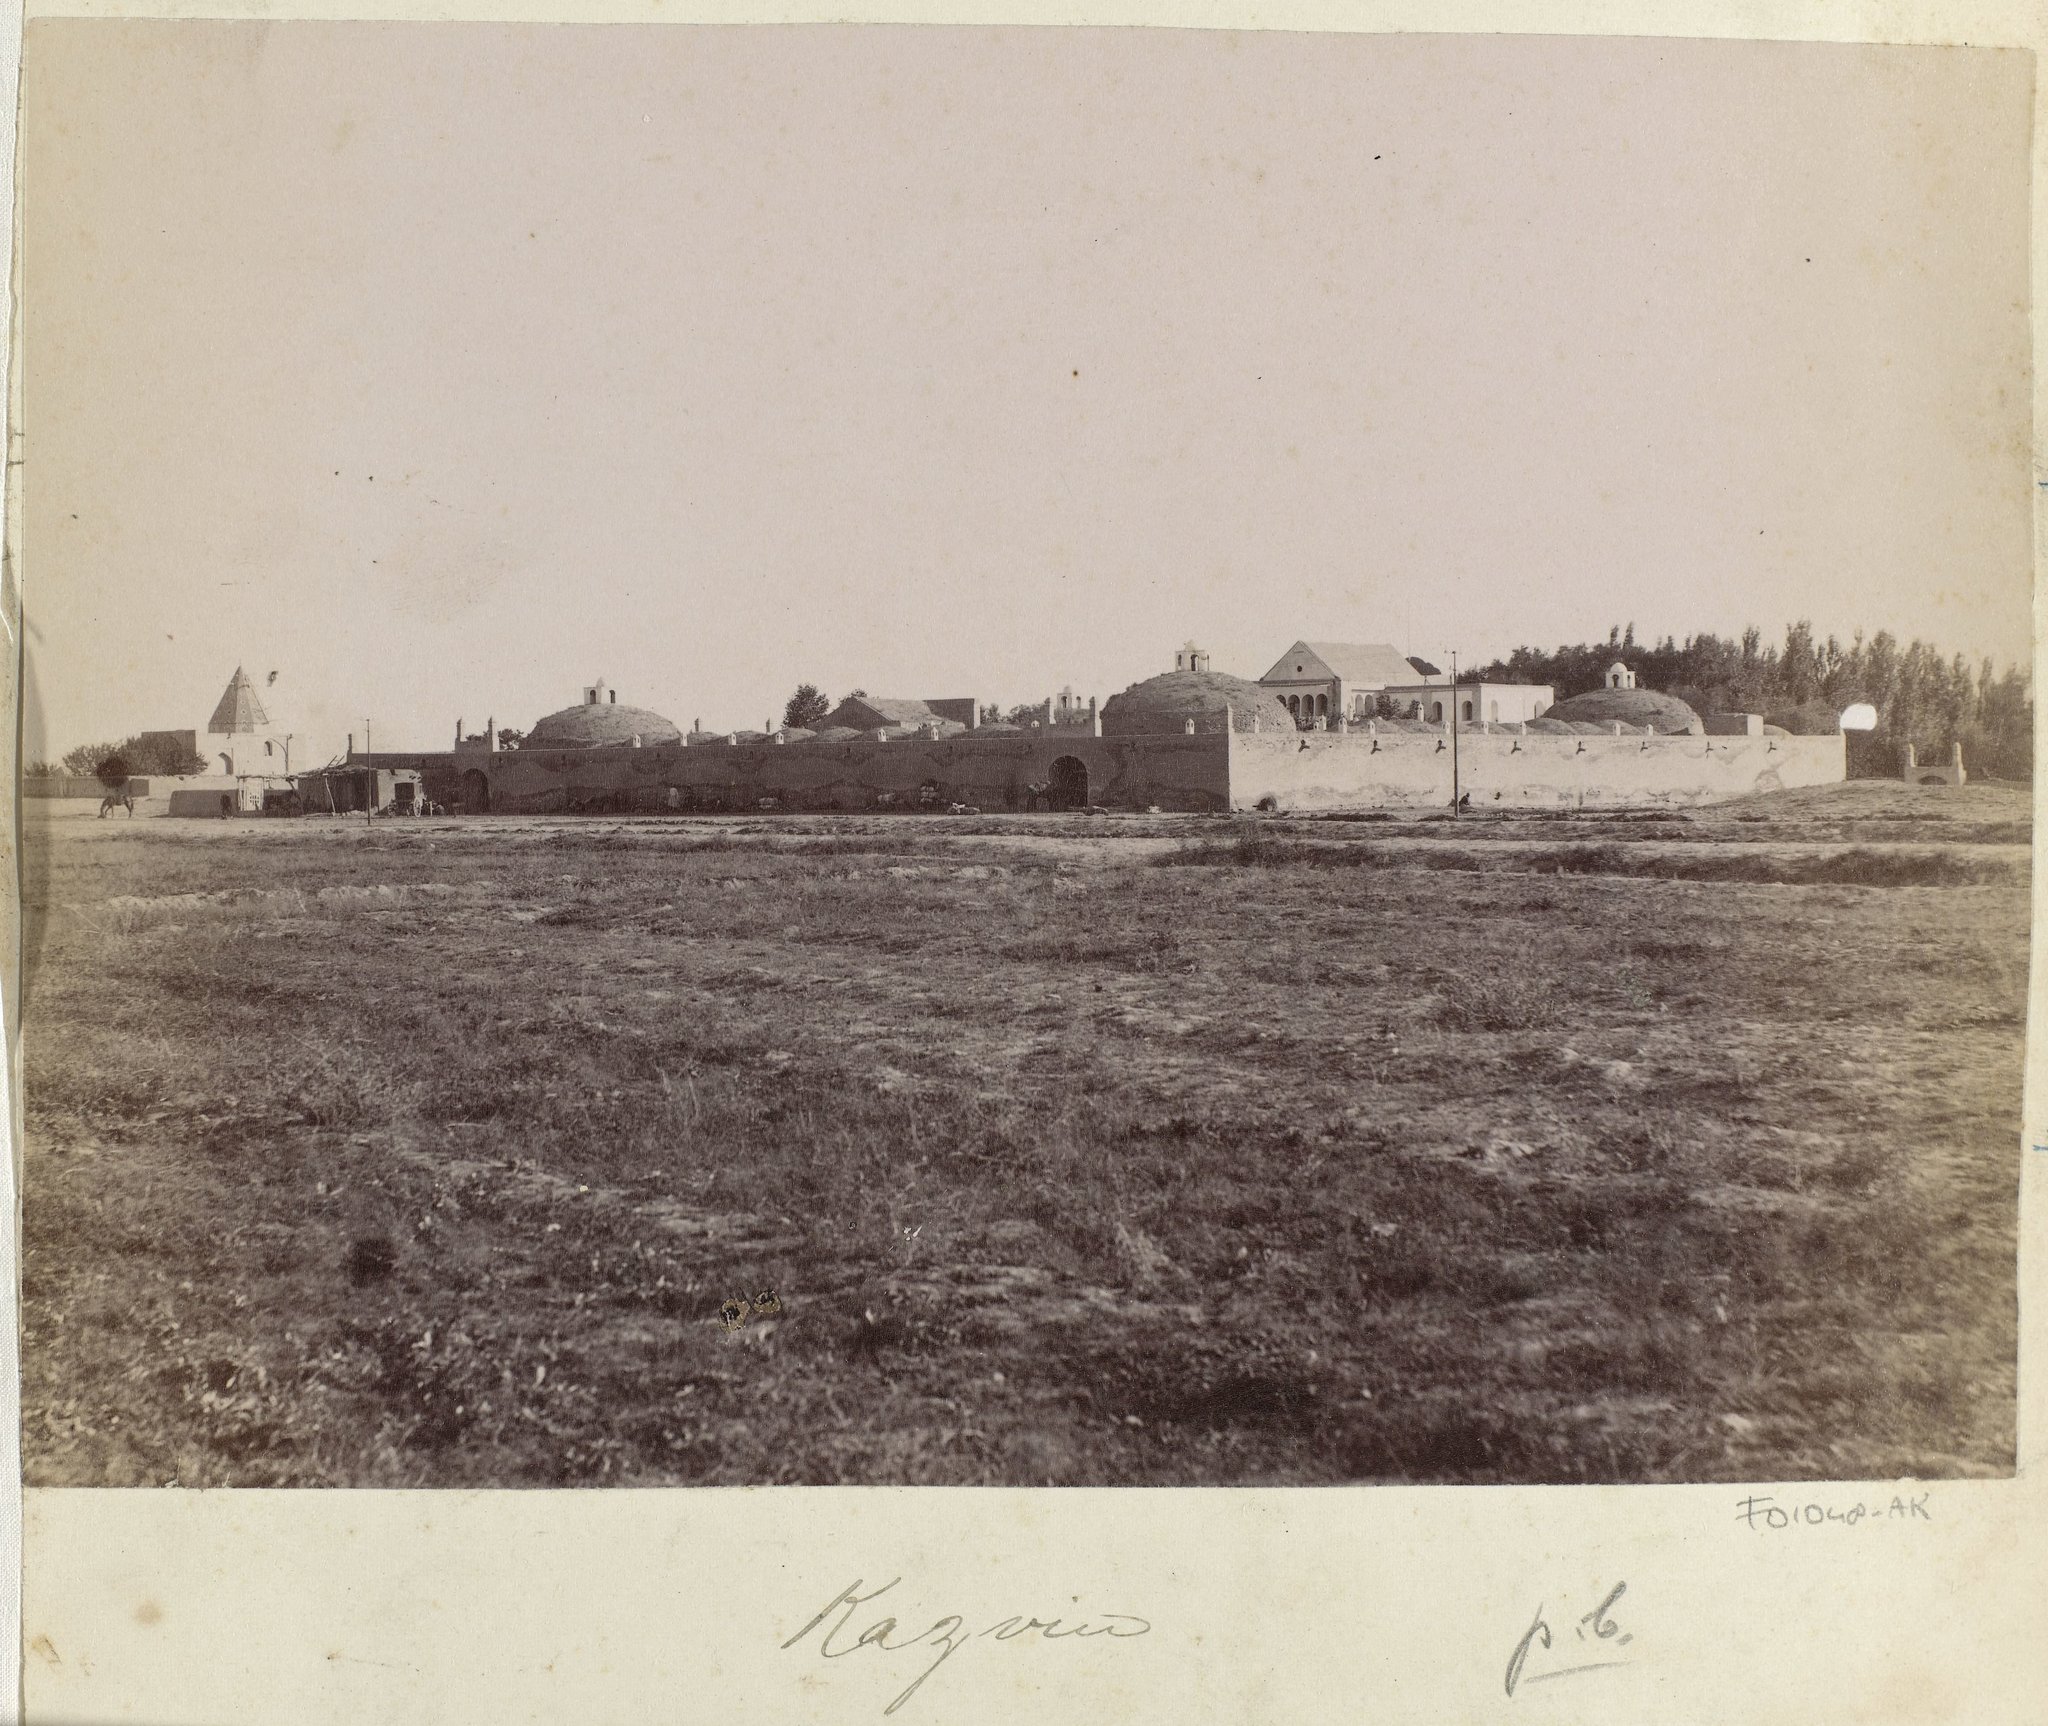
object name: photograph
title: Gezicht op een huis met een ommuurde hof in Qazvin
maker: antoine sevruguin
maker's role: fotograaf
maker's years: 1840-1933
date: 1880-1895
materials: paper, photographic support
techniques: albumen print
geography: qazvin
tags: fortress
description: Onderdeel van Reisalbum van H. Dunlop met foto's van bezienswaardigheden in Perzië, Schotland, Duitsland, Rusland, China en Canada.